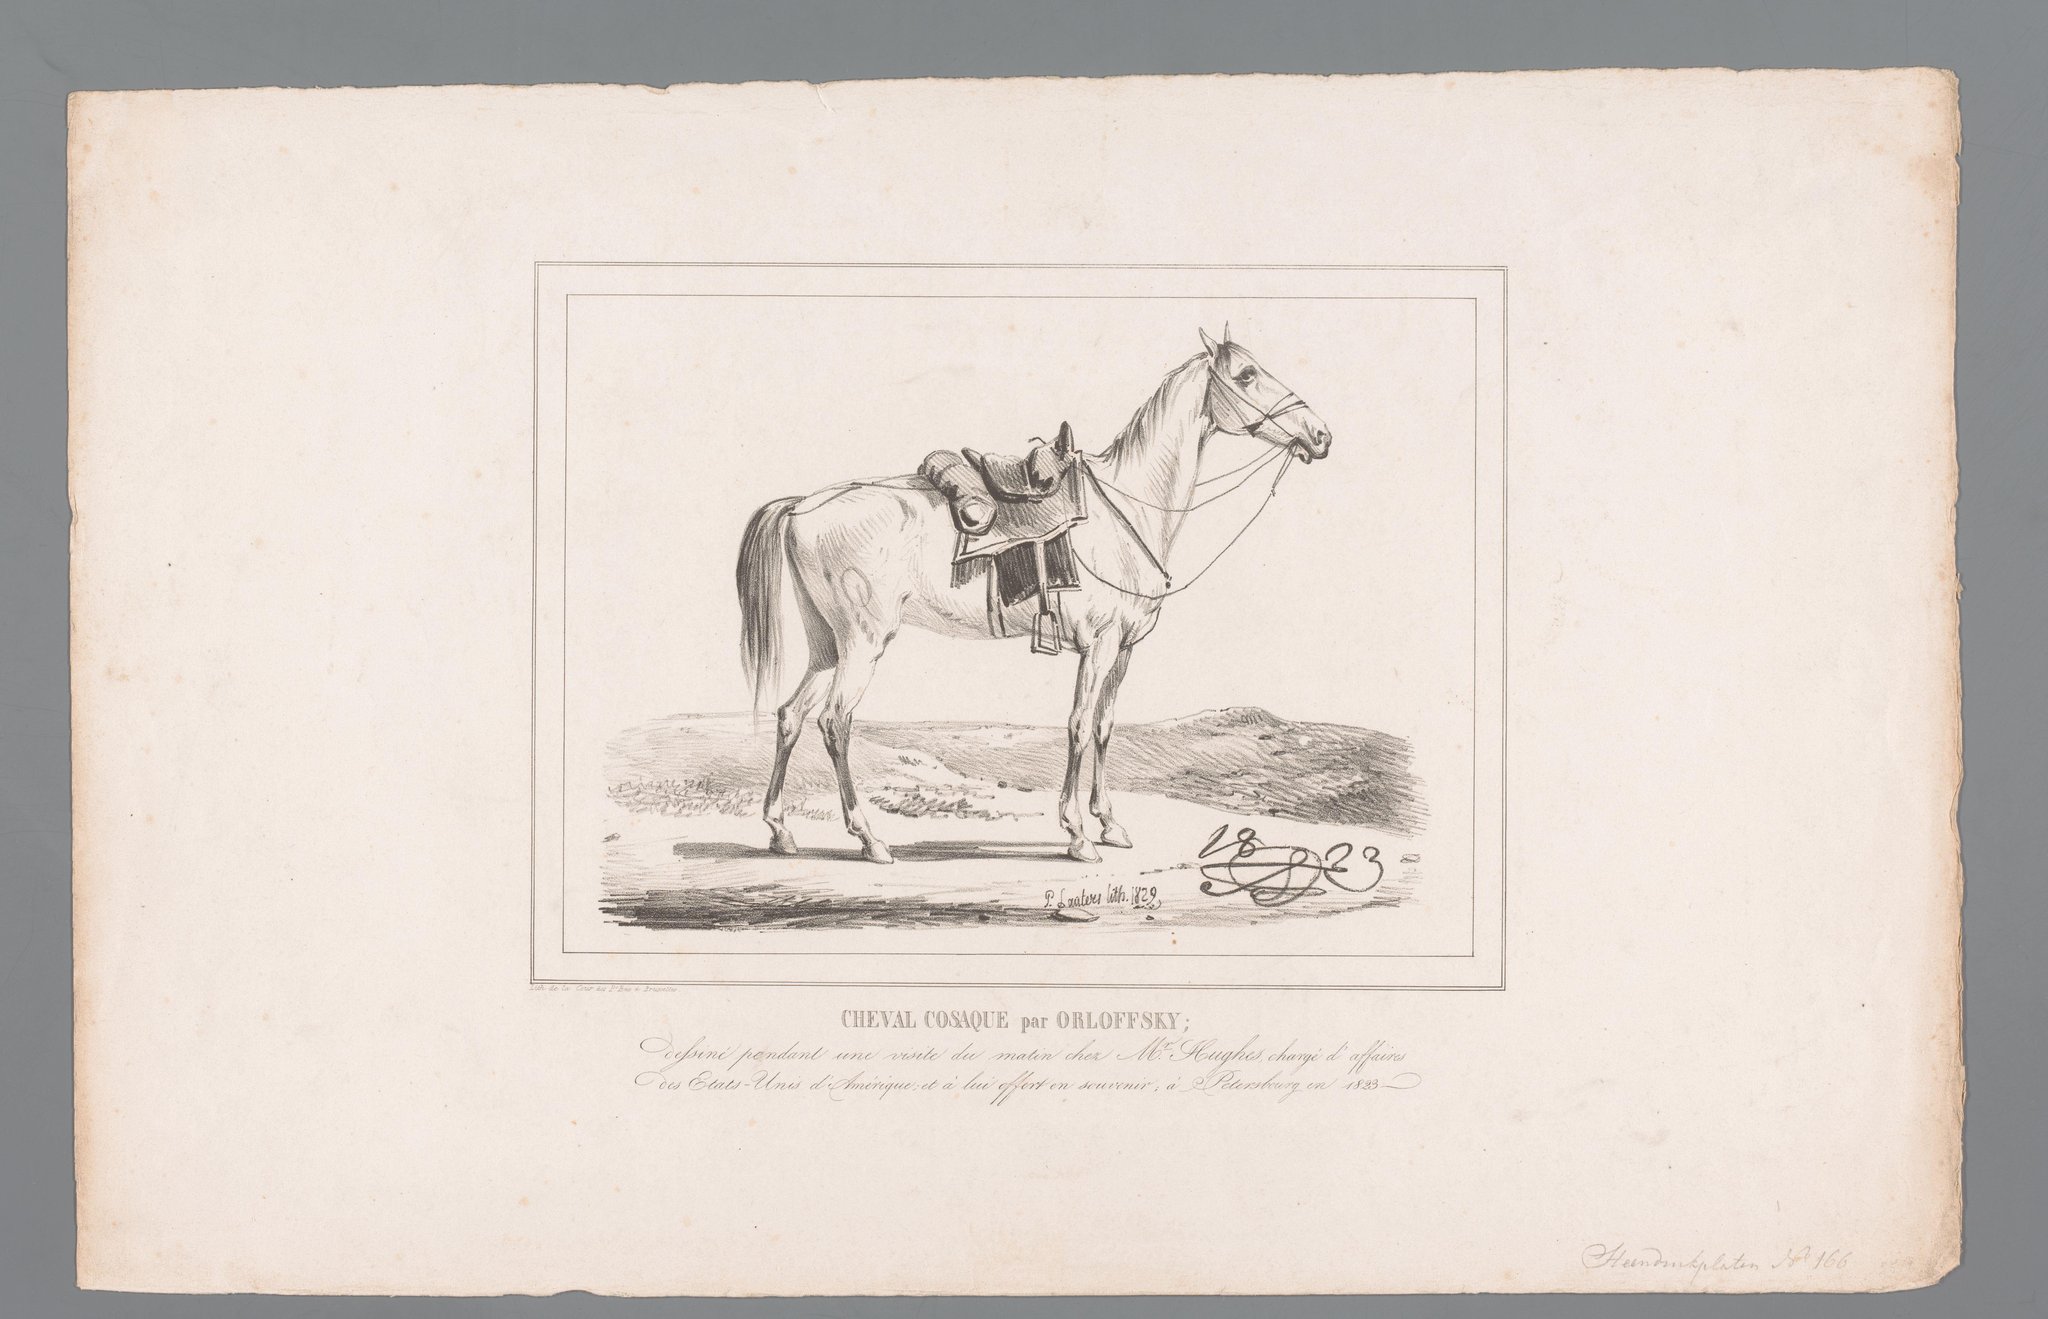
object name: print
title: Kozakken paard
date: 1829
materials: paper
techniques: lithograph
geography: brussels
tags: saddle and bridle (saddlery), horse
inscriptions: collector's mark: Lugt 2228